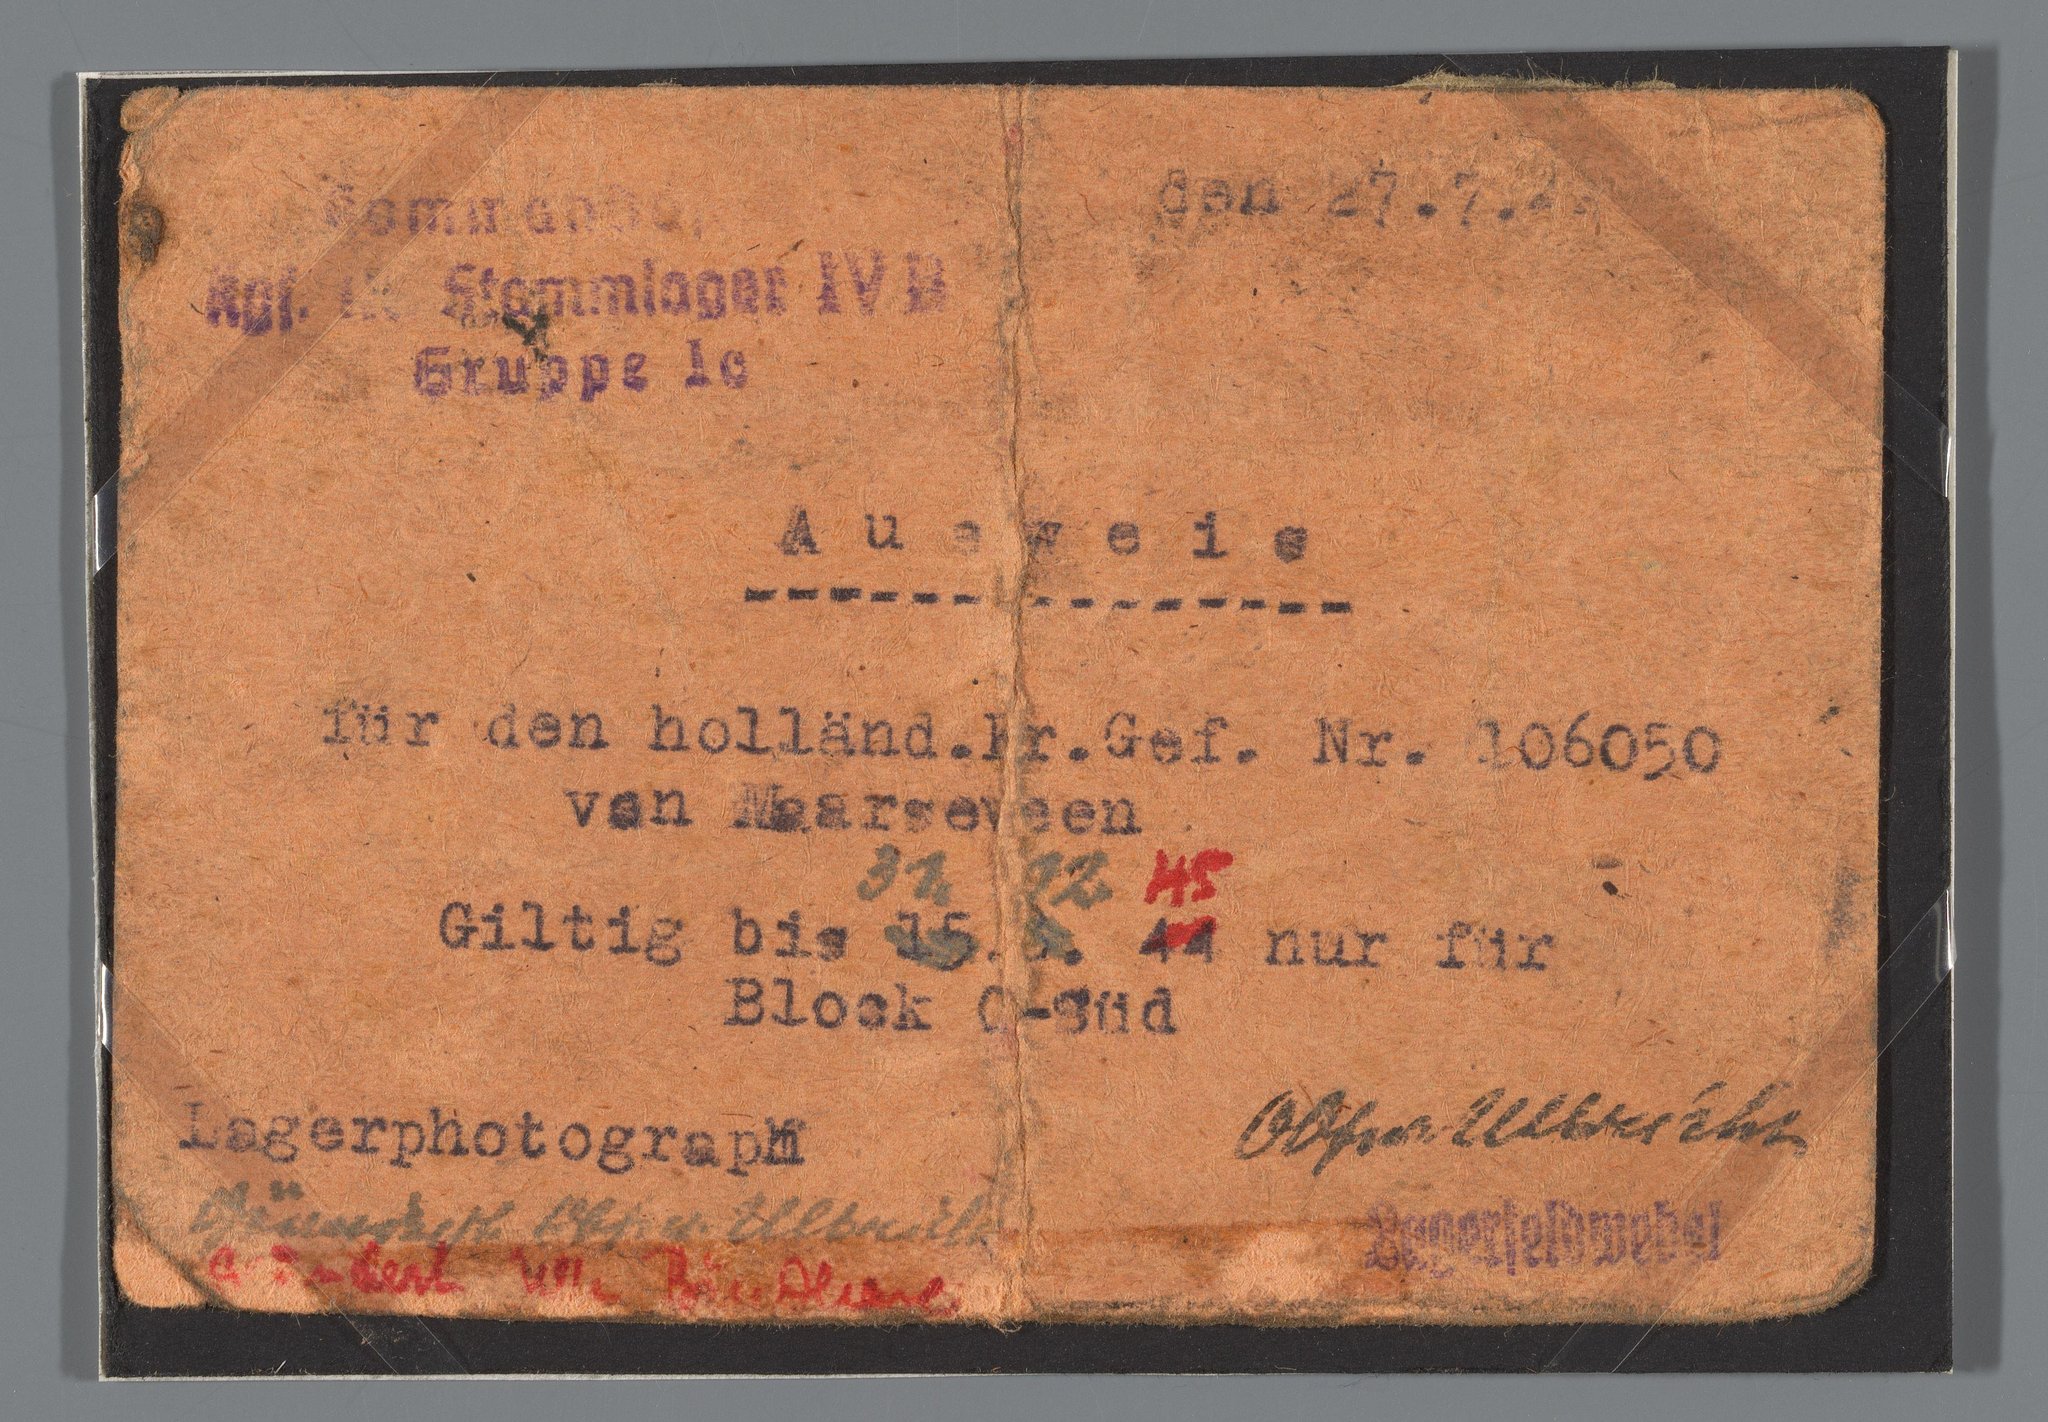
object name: identity card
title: Ausweis van D. van Maarseveen, kampfotograaf, voor het Duitse krijgsgevangenenkamp Stalag IV B in Mühlberg a/d Elbe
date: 1944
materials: paper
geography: muhlberg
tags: the hague, dick w.b. van maarseveen, prisoner of war camp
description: Oranje Ausweis 'für den holländ.hr.Gef. Nr. 106050 van Maarseveen', 'Giltig bis 31-02-45 nur für Block C-Süd', 'Lagerphotograph'. Met handtekeningen en stempel van 'lagerfeldwebel'. Gesleten. De meeste gegevens zijn getypt.